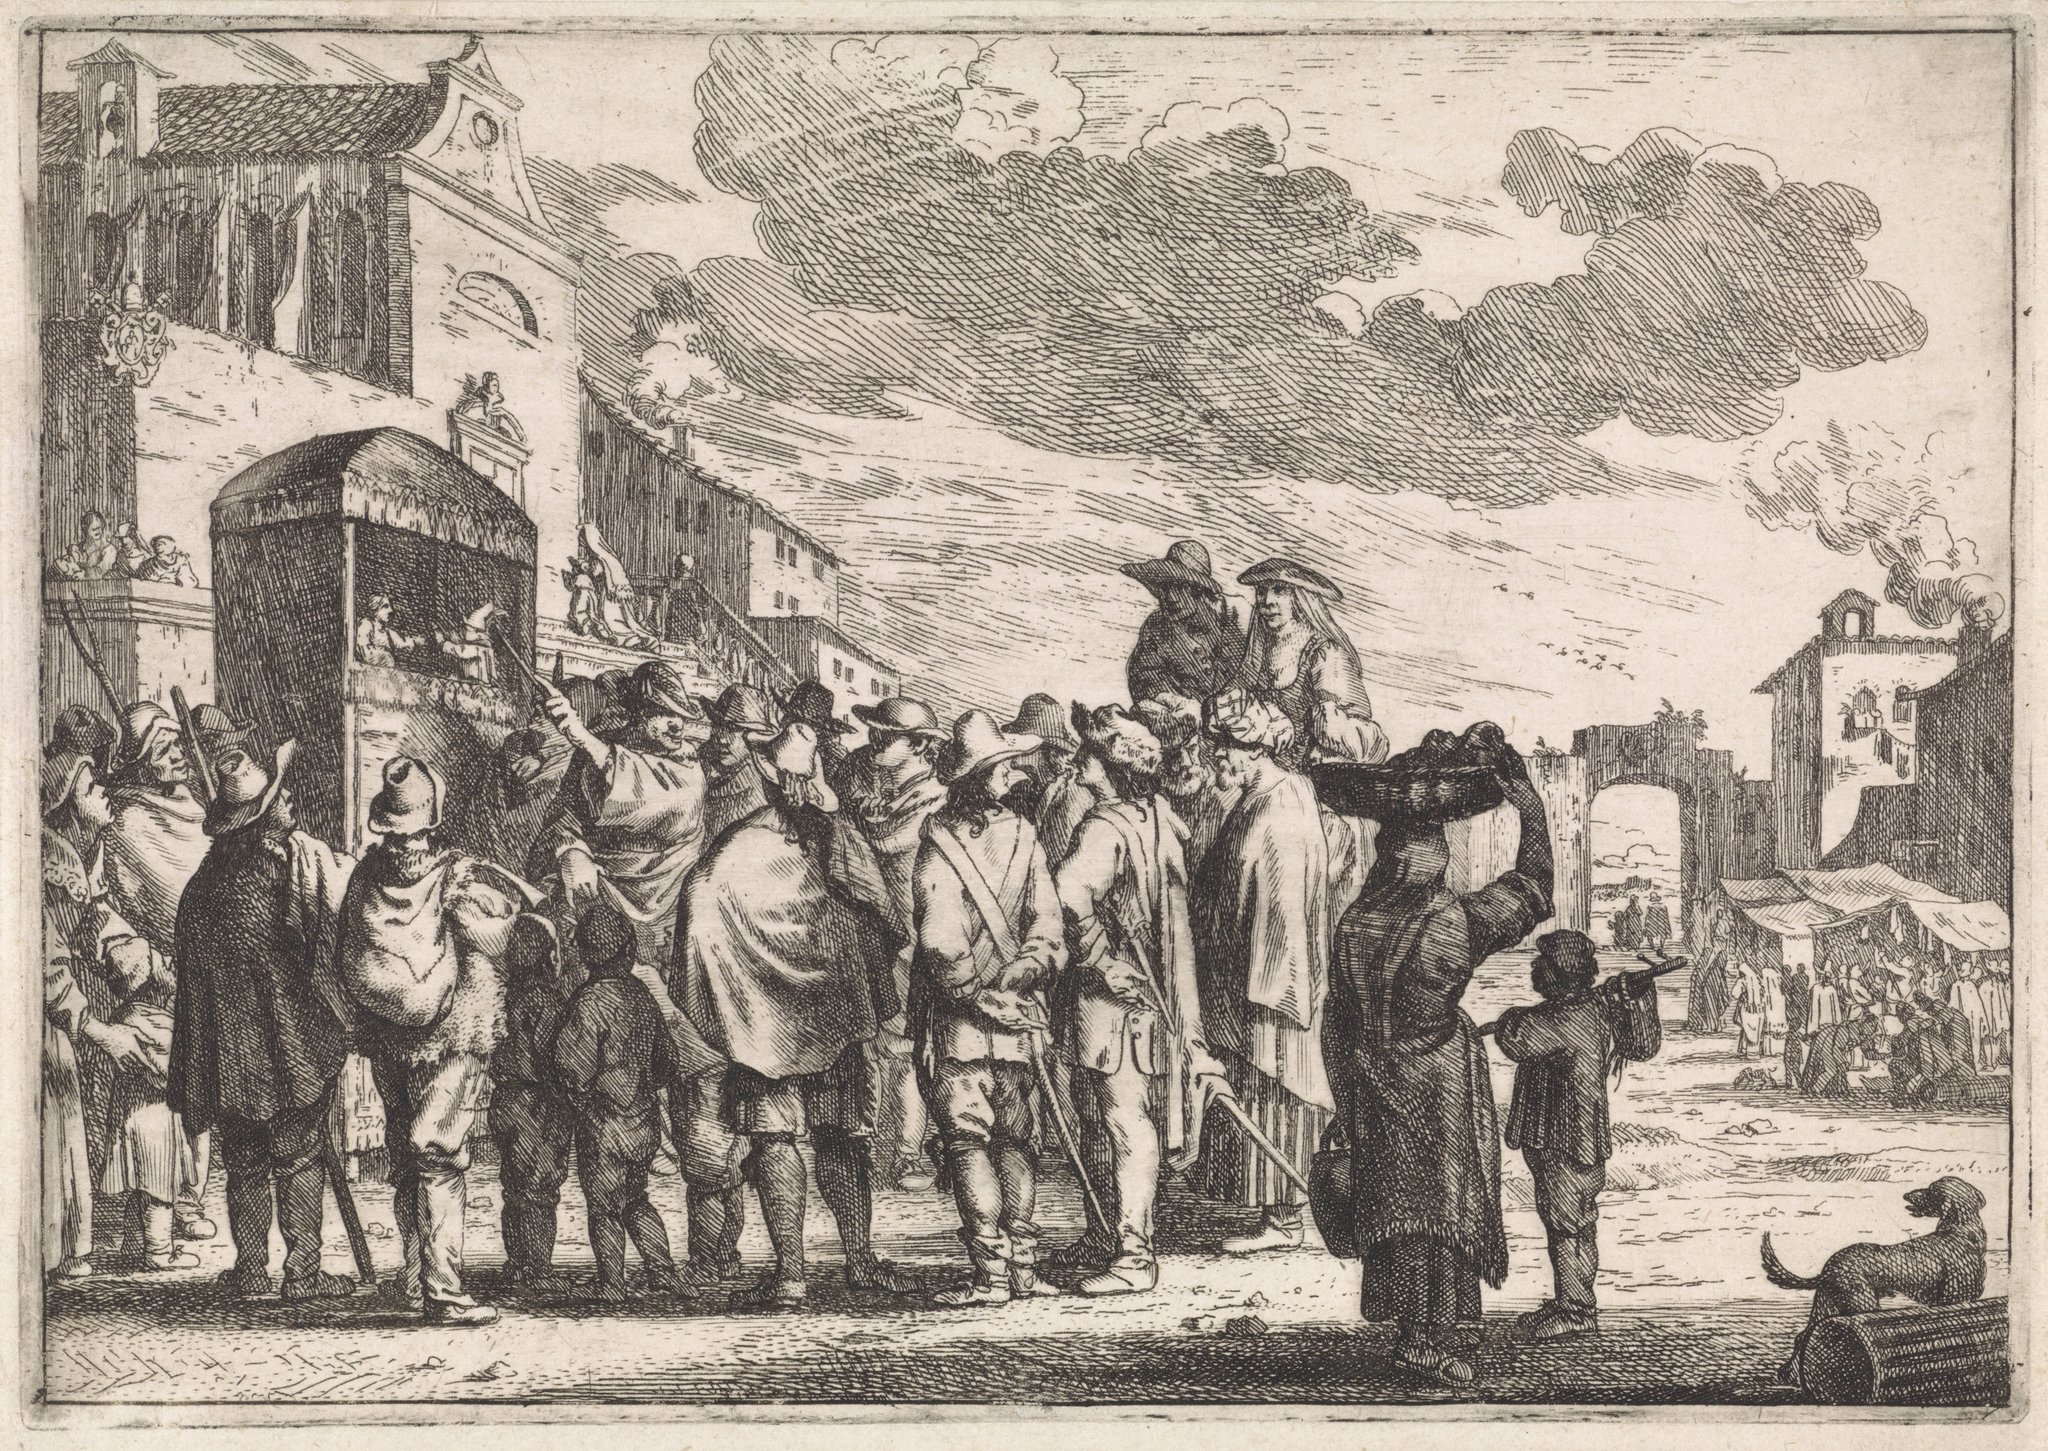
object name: print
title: Poppenkast te Rome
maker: cornelis de wael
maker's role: draughtsman, print maker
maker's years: 1592-1667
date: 1613-1667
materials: paper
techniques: etching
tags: church (exterior), puppet and marionette show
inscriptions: collector's mark: Lugt 2228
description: Toeschouwers kijken naar een poppenkast op een plein in Rome. Op de achtergrond knielen een moeder en een kind in gebed op de trappen van een kerk.